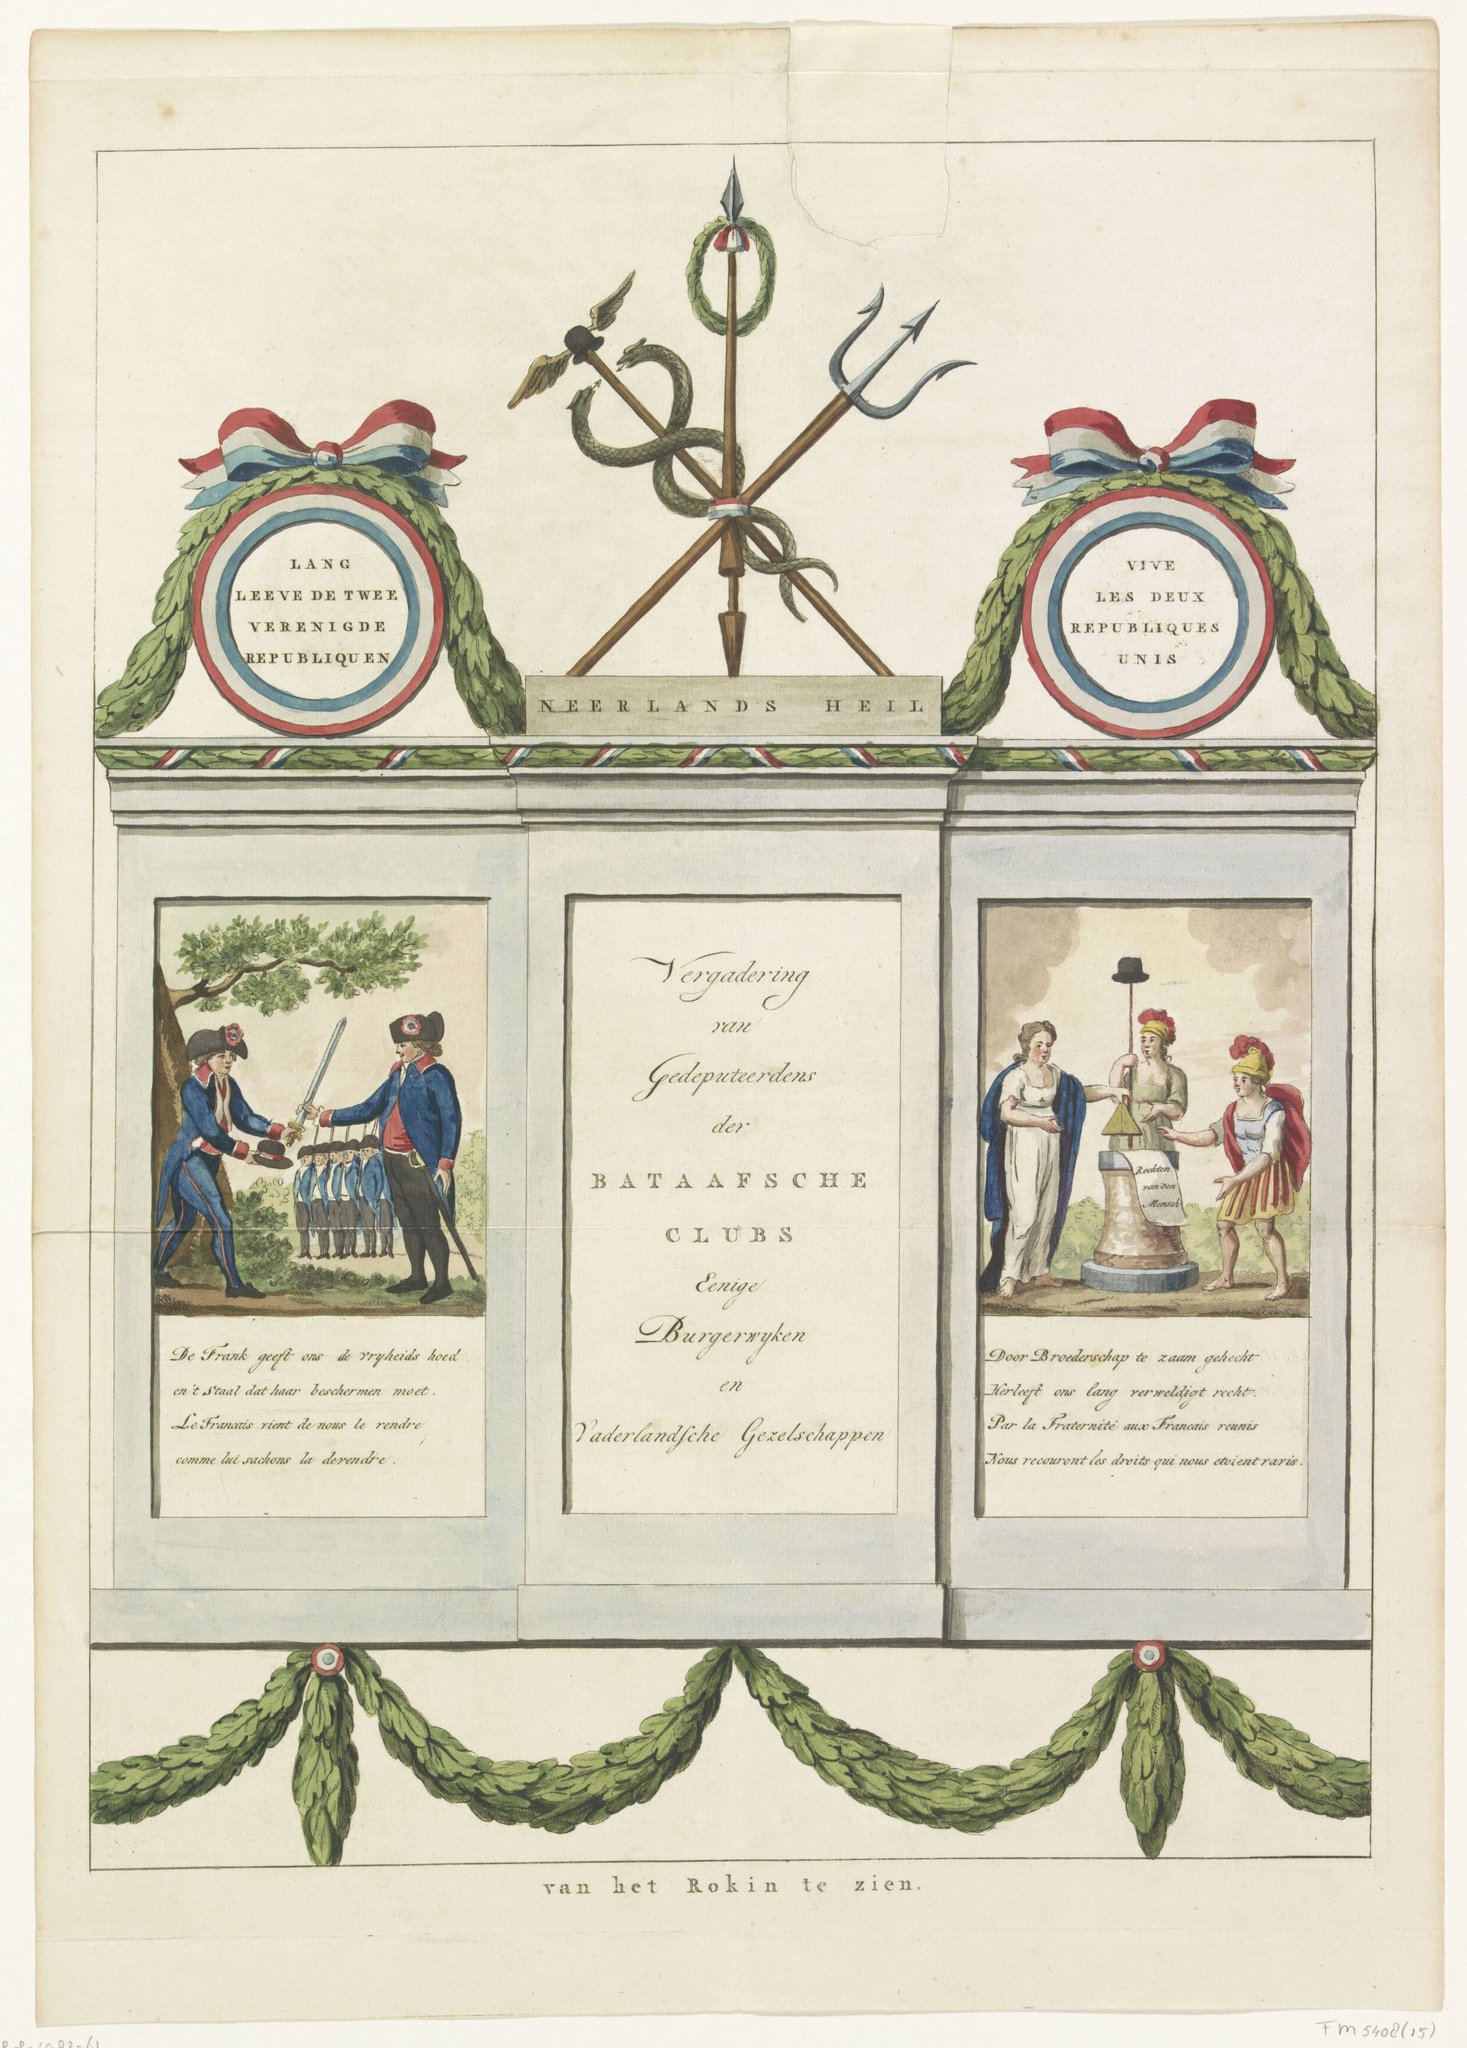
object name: print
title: Vijftien decoraties bij het Alliantiefeest te Amsterdam in 1795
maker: Anonymous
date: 1795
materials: paper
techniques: etching, hand coloring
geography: netherlands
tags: festivities on events of national importance (+ festive decoration ~ festive activities), amsterdam, alliance with france (1795)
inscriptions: collector's mark: Lugt 2228, collector's mark: Lugt 2760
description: Decoratie in de Beurssteeg, gezien vanaf het Rokin, 1795. Opgericht door een Vergadering van Gedeputeerden van de Bataafsche Clubs, Burgerwijken en Vaderlandsche Gezelschappen te Amsterdam bij het Alliantiefeest op 19 juni 1795. Op de twee chassinetten allegorieën van de vrijheid door Frankrijks wapens en van de Rechten van de Mens, elk met een vierregelig vers.